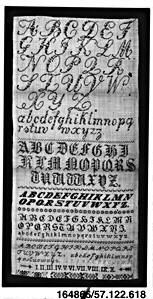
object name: sampler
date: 1801-1900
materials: canvas, silk, wool